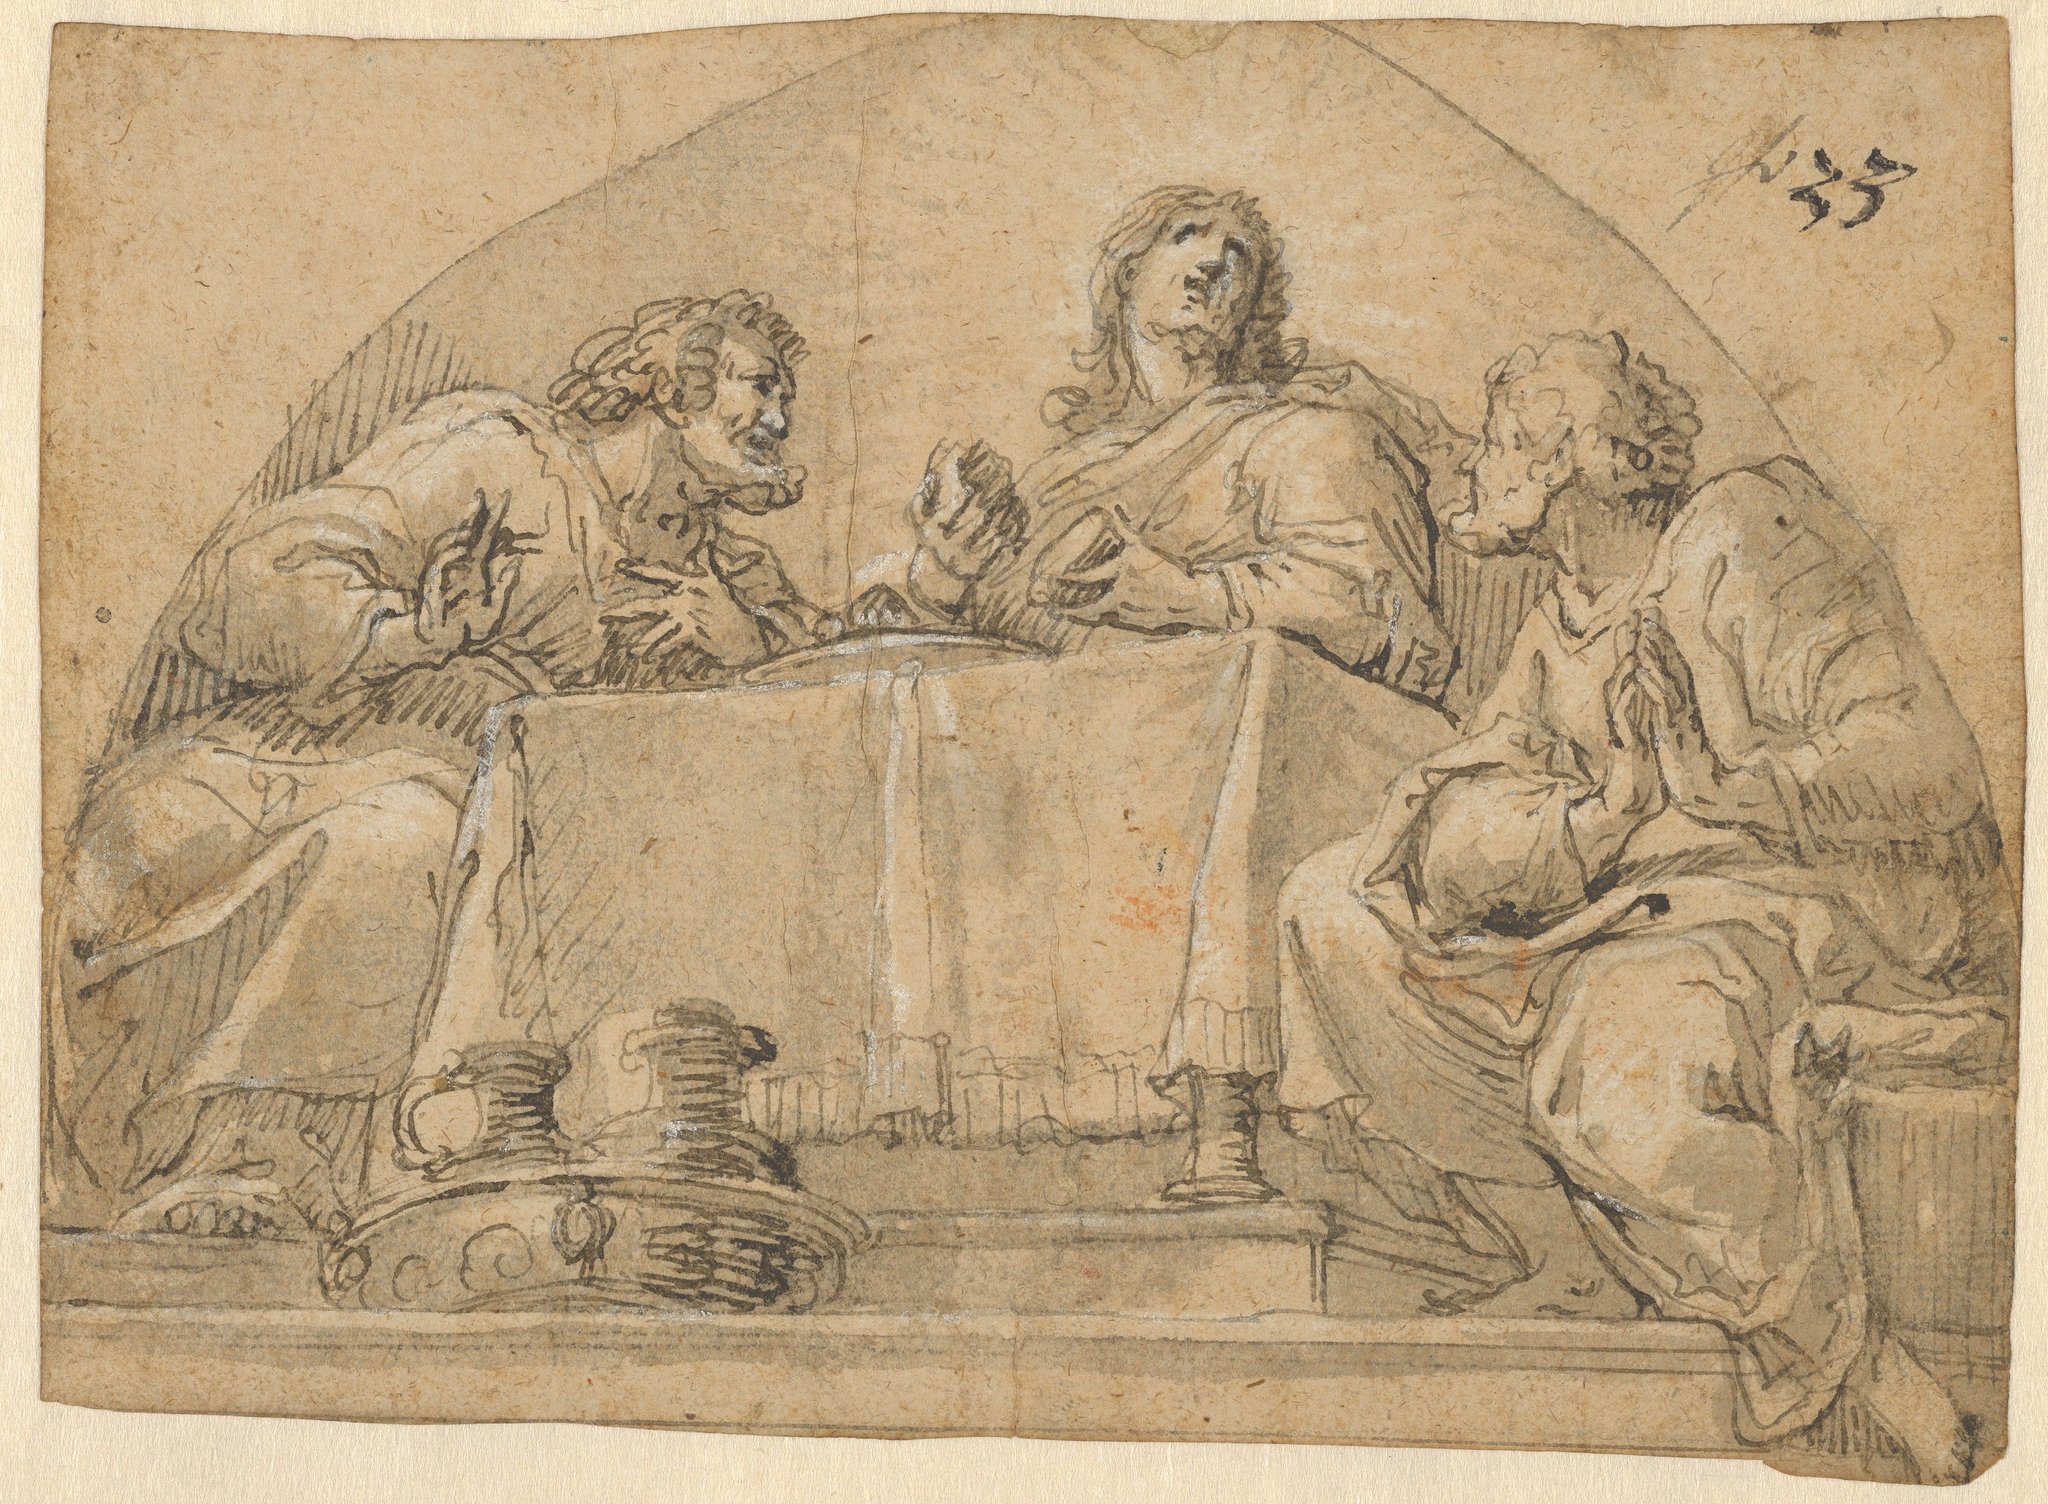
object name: drawing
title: Christ at Emmaus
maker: hans georg asam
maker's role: artist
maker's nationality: german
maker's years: 1649-1711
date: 1690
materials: gouache, ink, paper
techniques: heightening, pen, wash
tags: men,christ